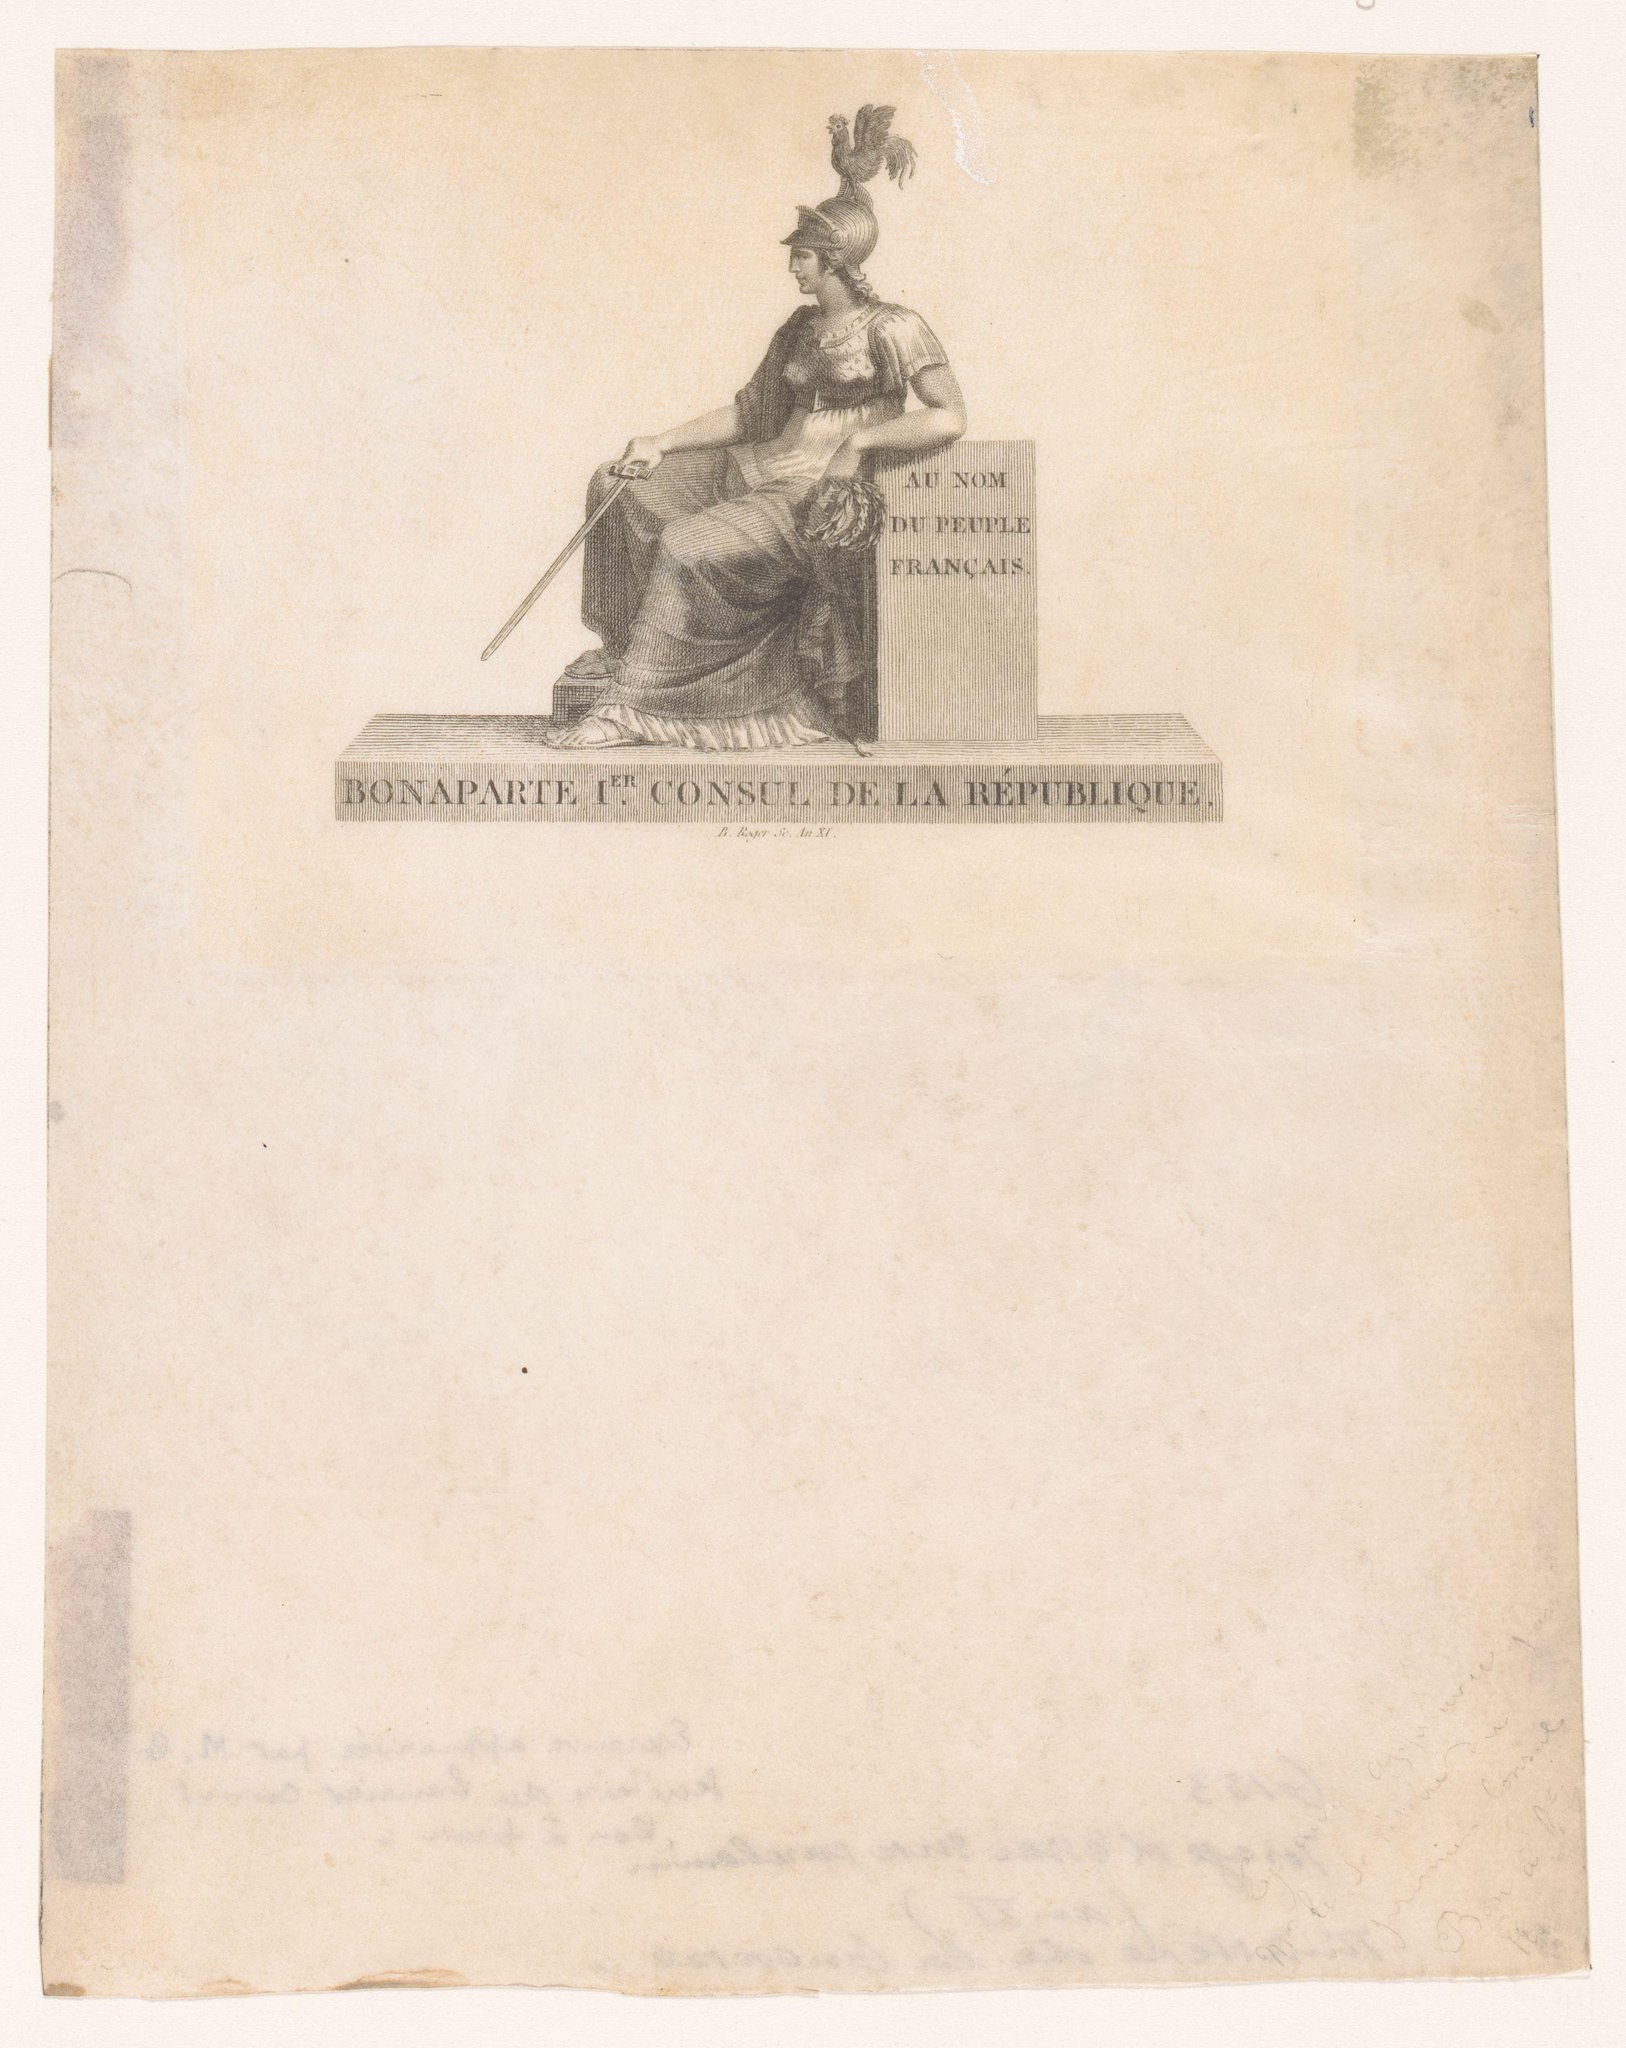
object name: print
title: Au nom du peuple Français/ Bonaparte I.er consul de la République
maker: barthélémy joseph fulcran roger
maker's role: print maker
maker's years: 1767-1841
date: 1799-1804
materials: parchment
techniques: etching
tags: governmental and representative bodies, personifications of countries, nations, states, districts, etc., warfare; military affairs, letter, envelope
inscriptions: collector's mark: Lugt 2228, annotation: ‘Epreuve approvée par M. le/ secrétaire du Premier consul./ Bon à tirer.’